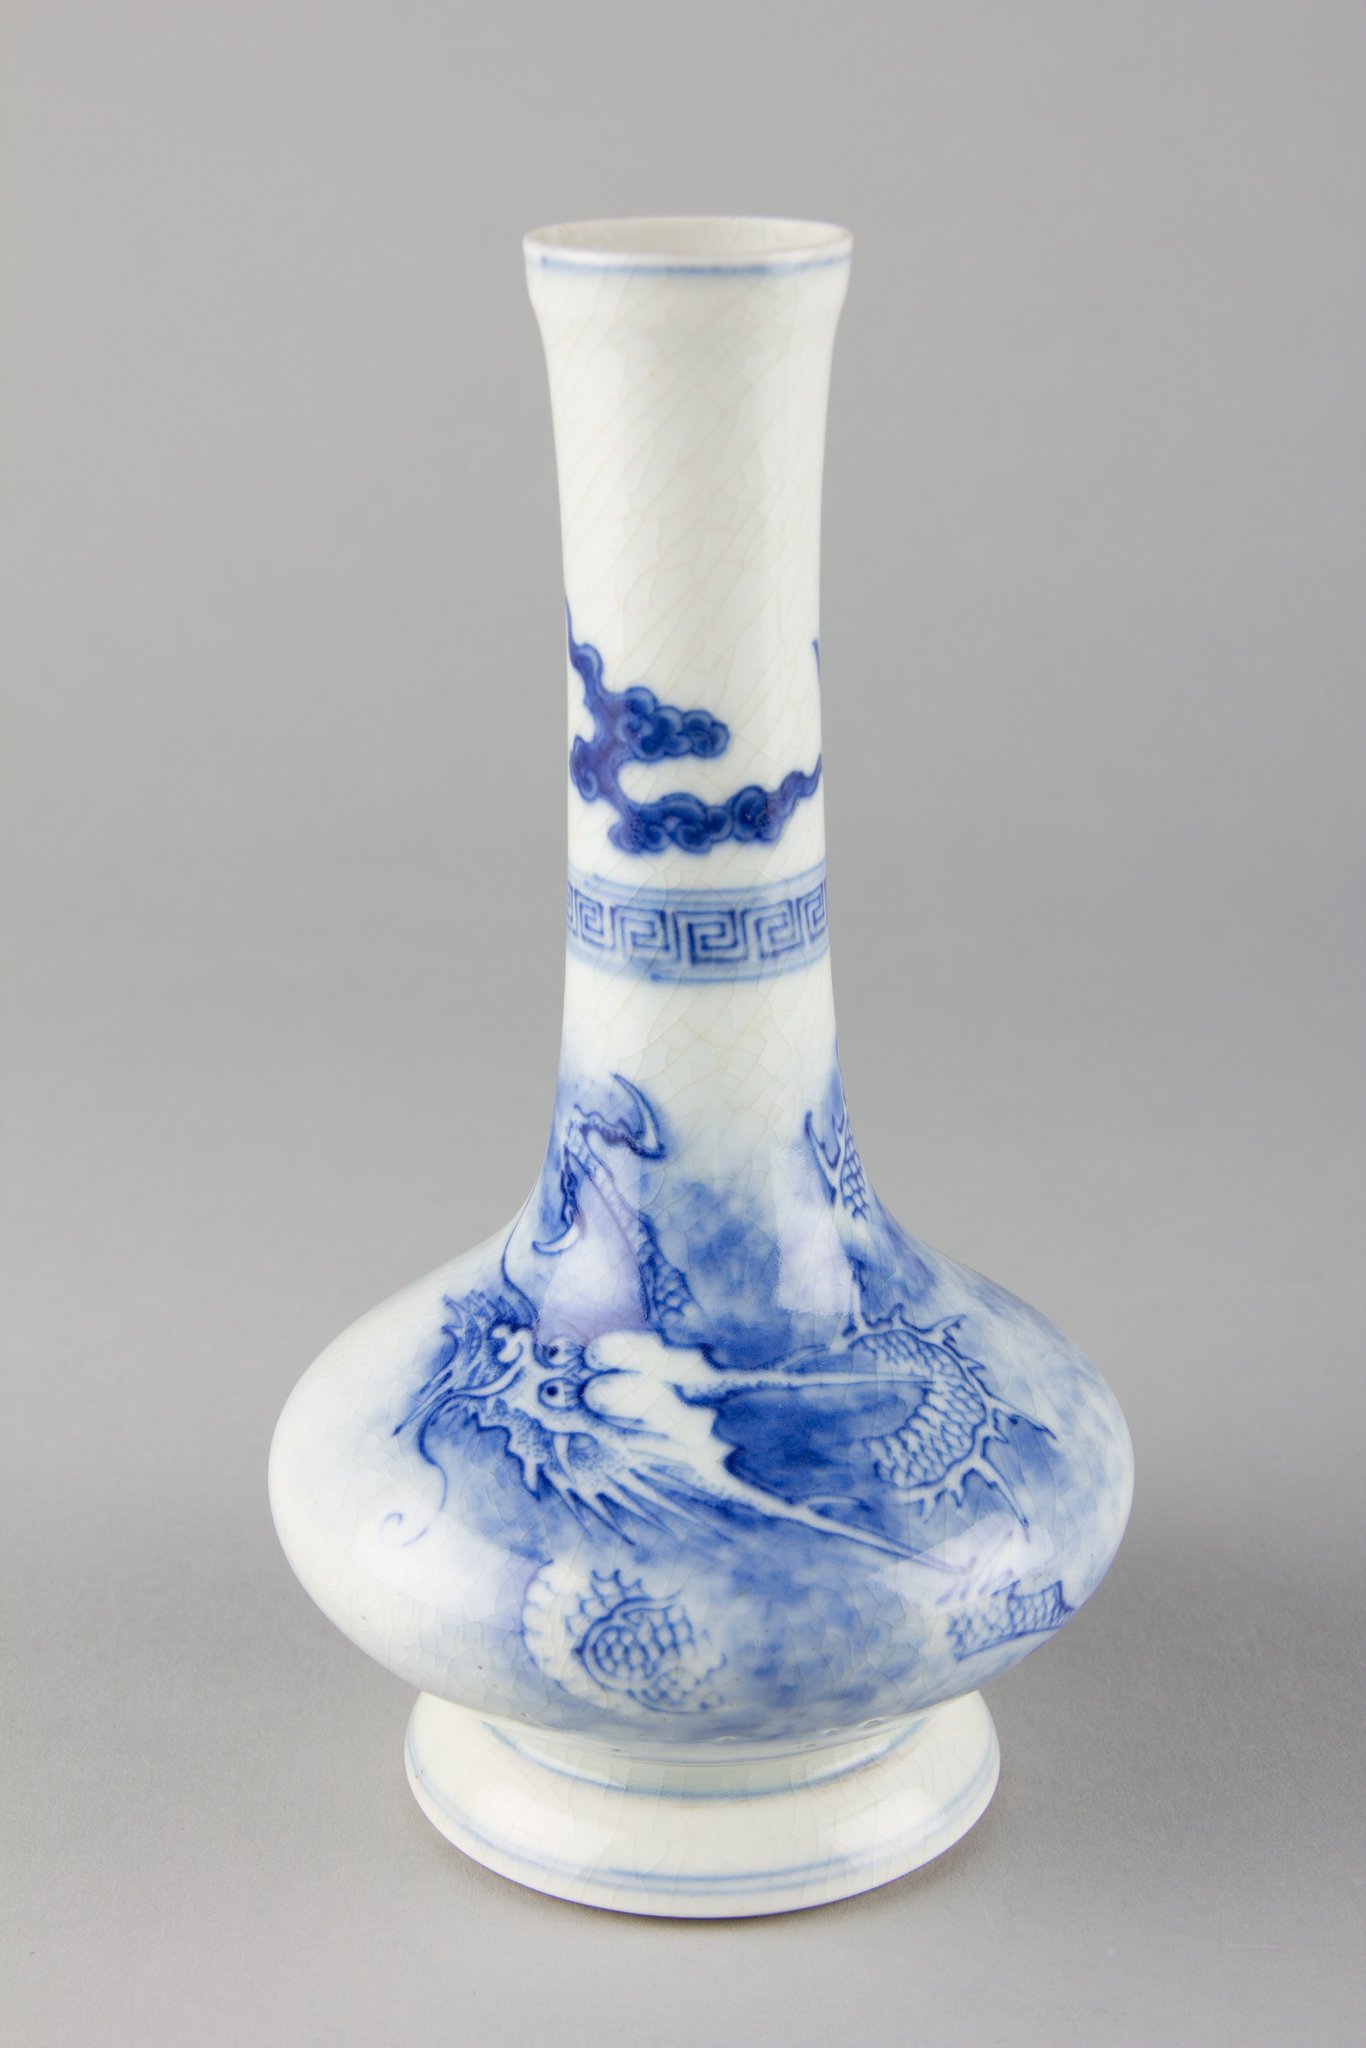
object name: bottle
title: Vase with dragon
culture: chinese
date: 1767-1800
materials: cobalt, porcelain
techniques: painting, underglaze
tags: dragons